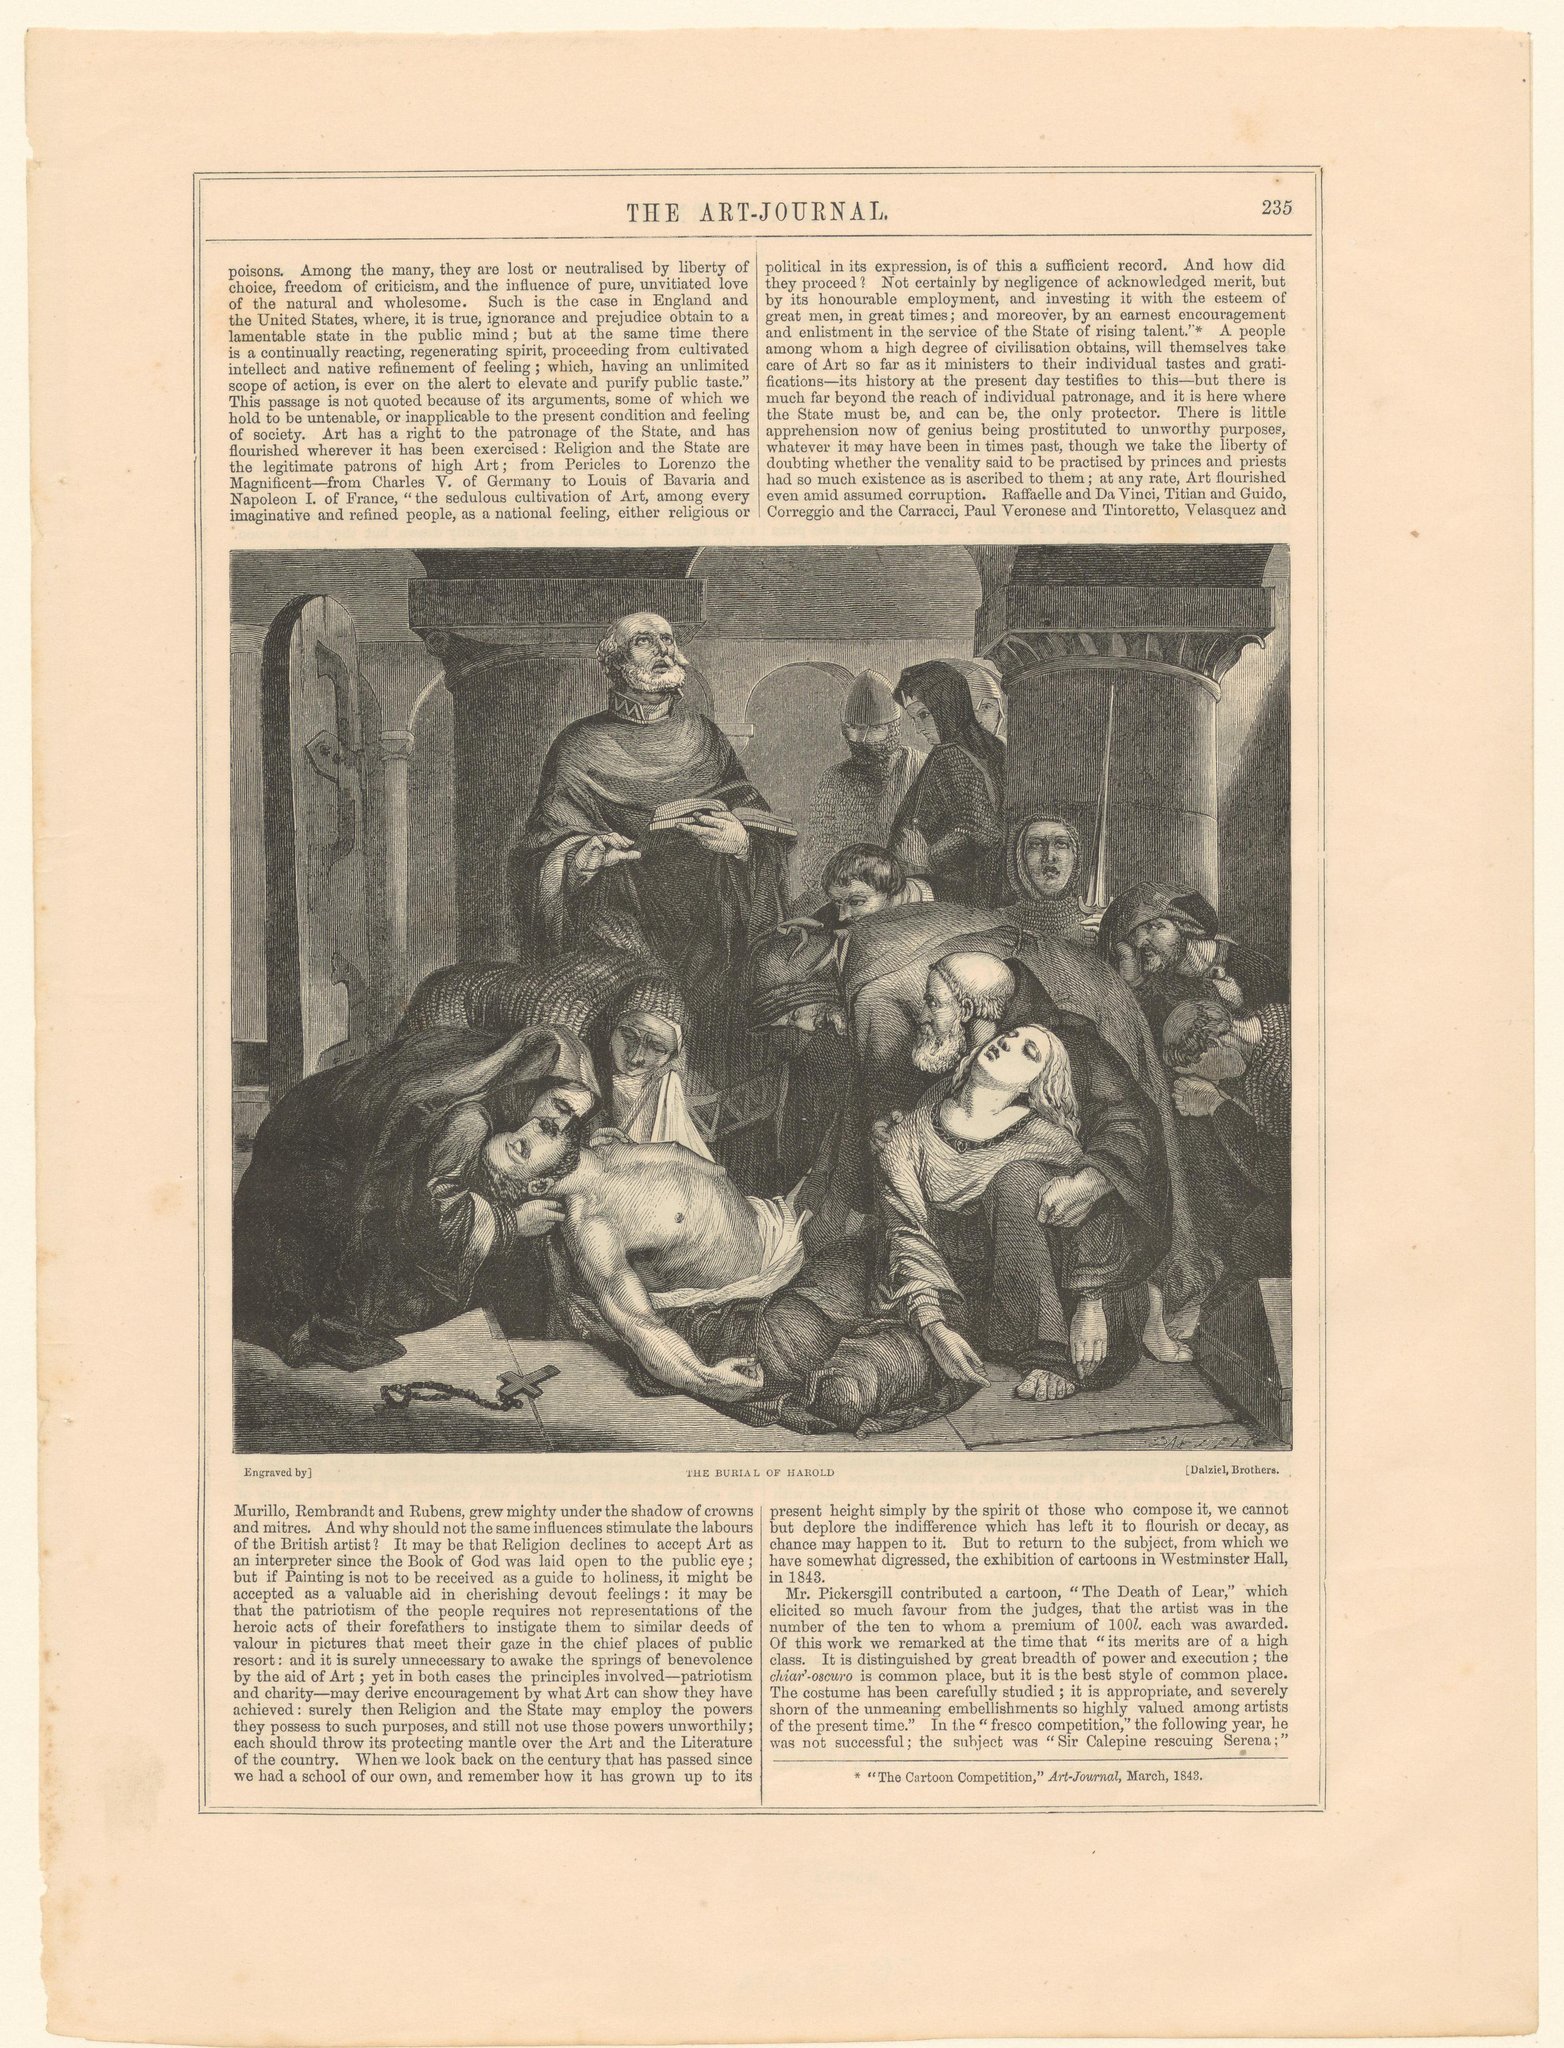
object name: print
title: The burial of Harold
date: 1855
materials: paper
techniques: letterpress printing, engraving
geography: london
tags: burial, preaching (in general)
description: Prent uit: The Art Journal 4 (1855), p. 235.